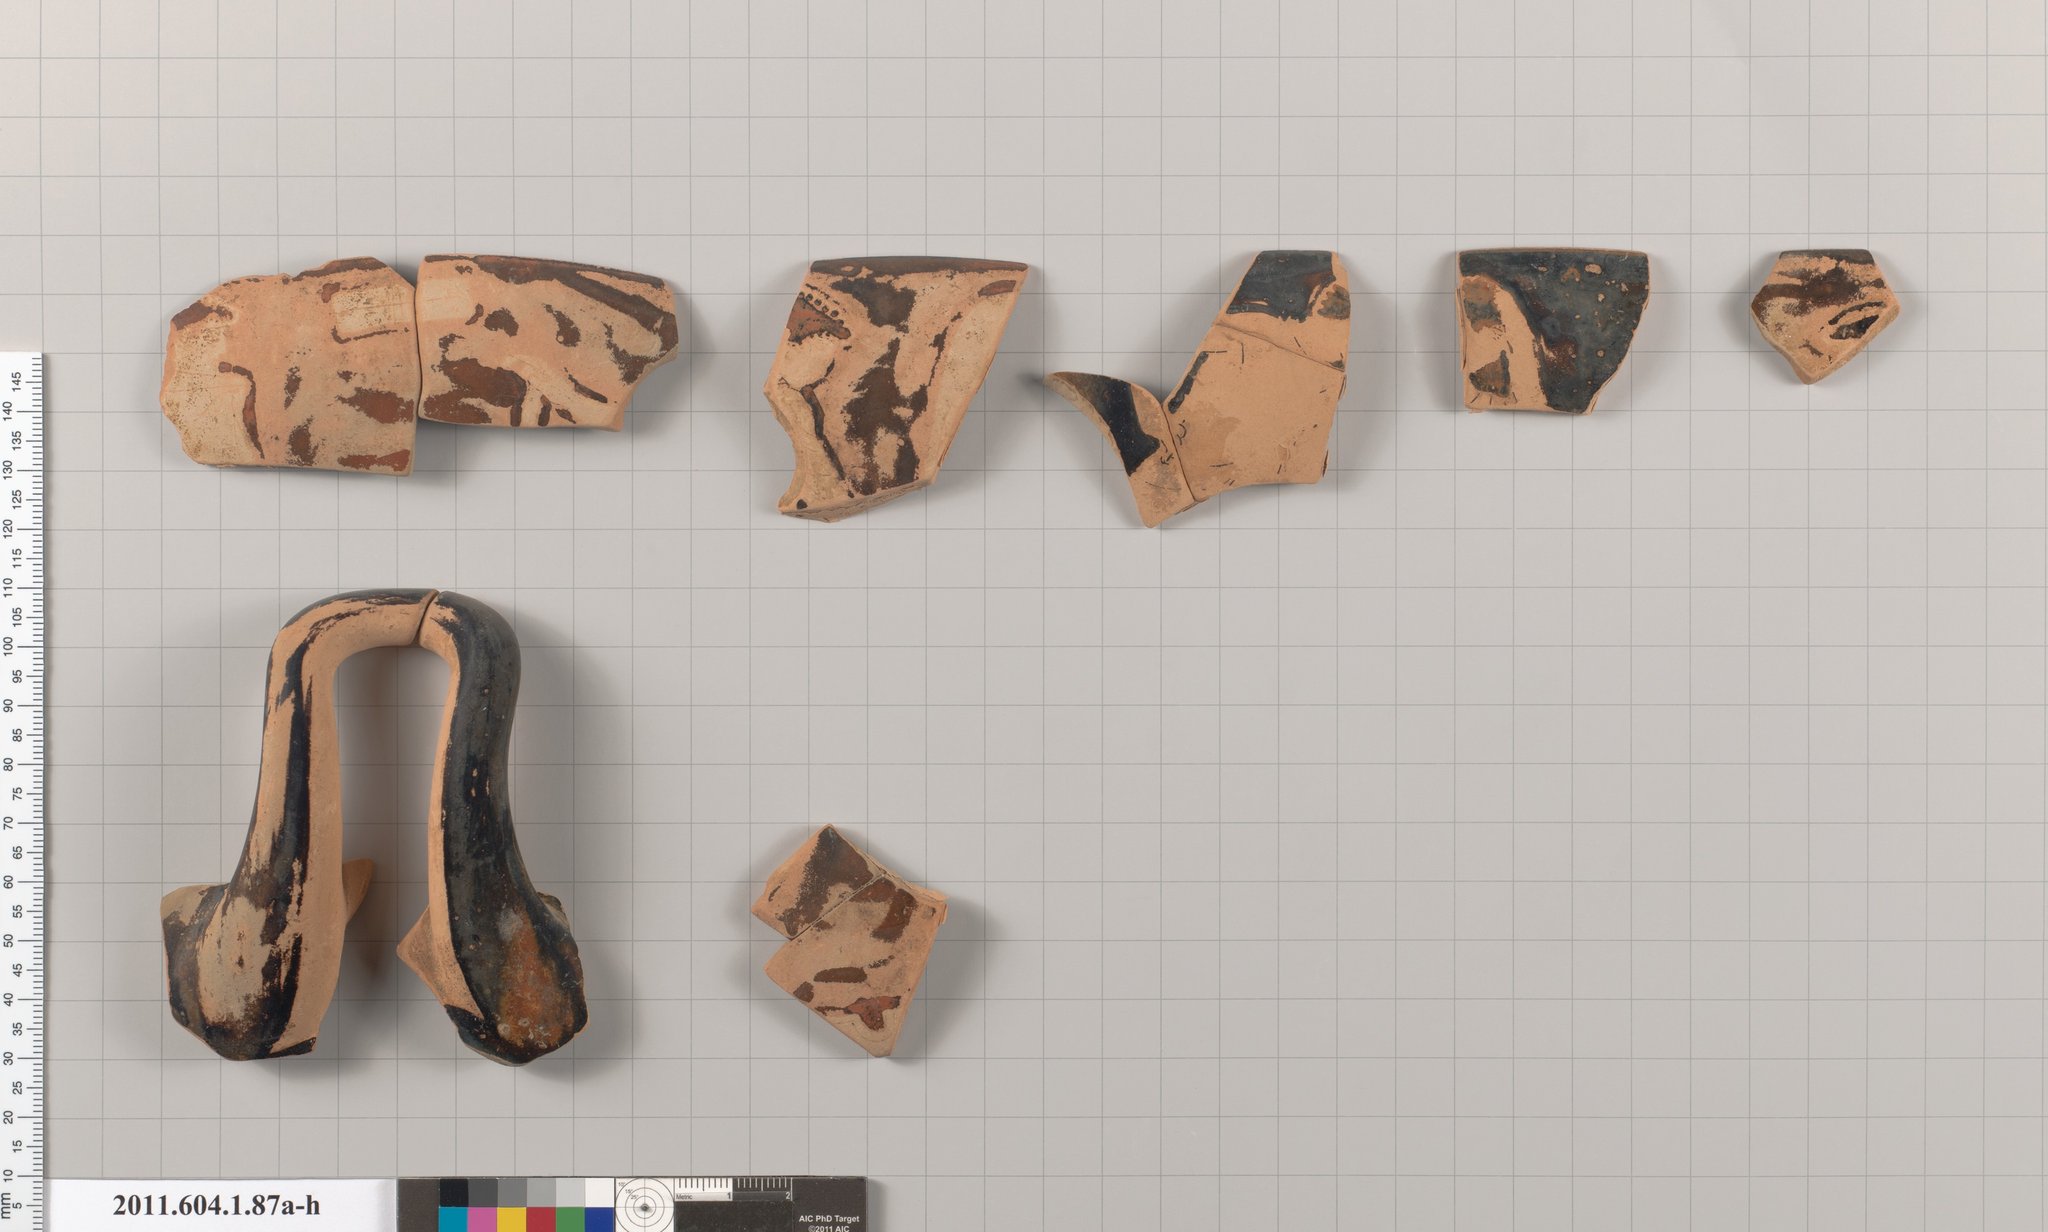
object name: kylix fragment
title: Terracotta fragments of a kylix (drinking cup)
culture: greek, attic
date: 475-451 BCE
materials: terracotta